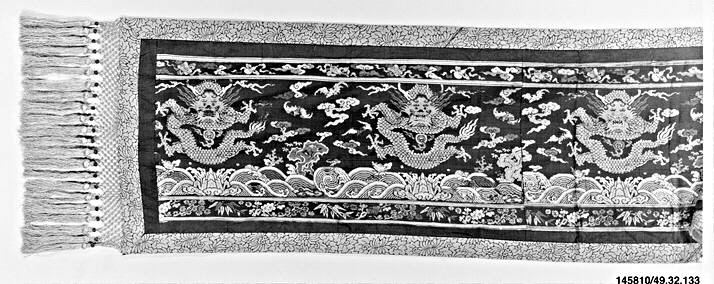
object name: runner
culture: chinese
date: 1867-1900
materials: silk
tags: bats,dragons